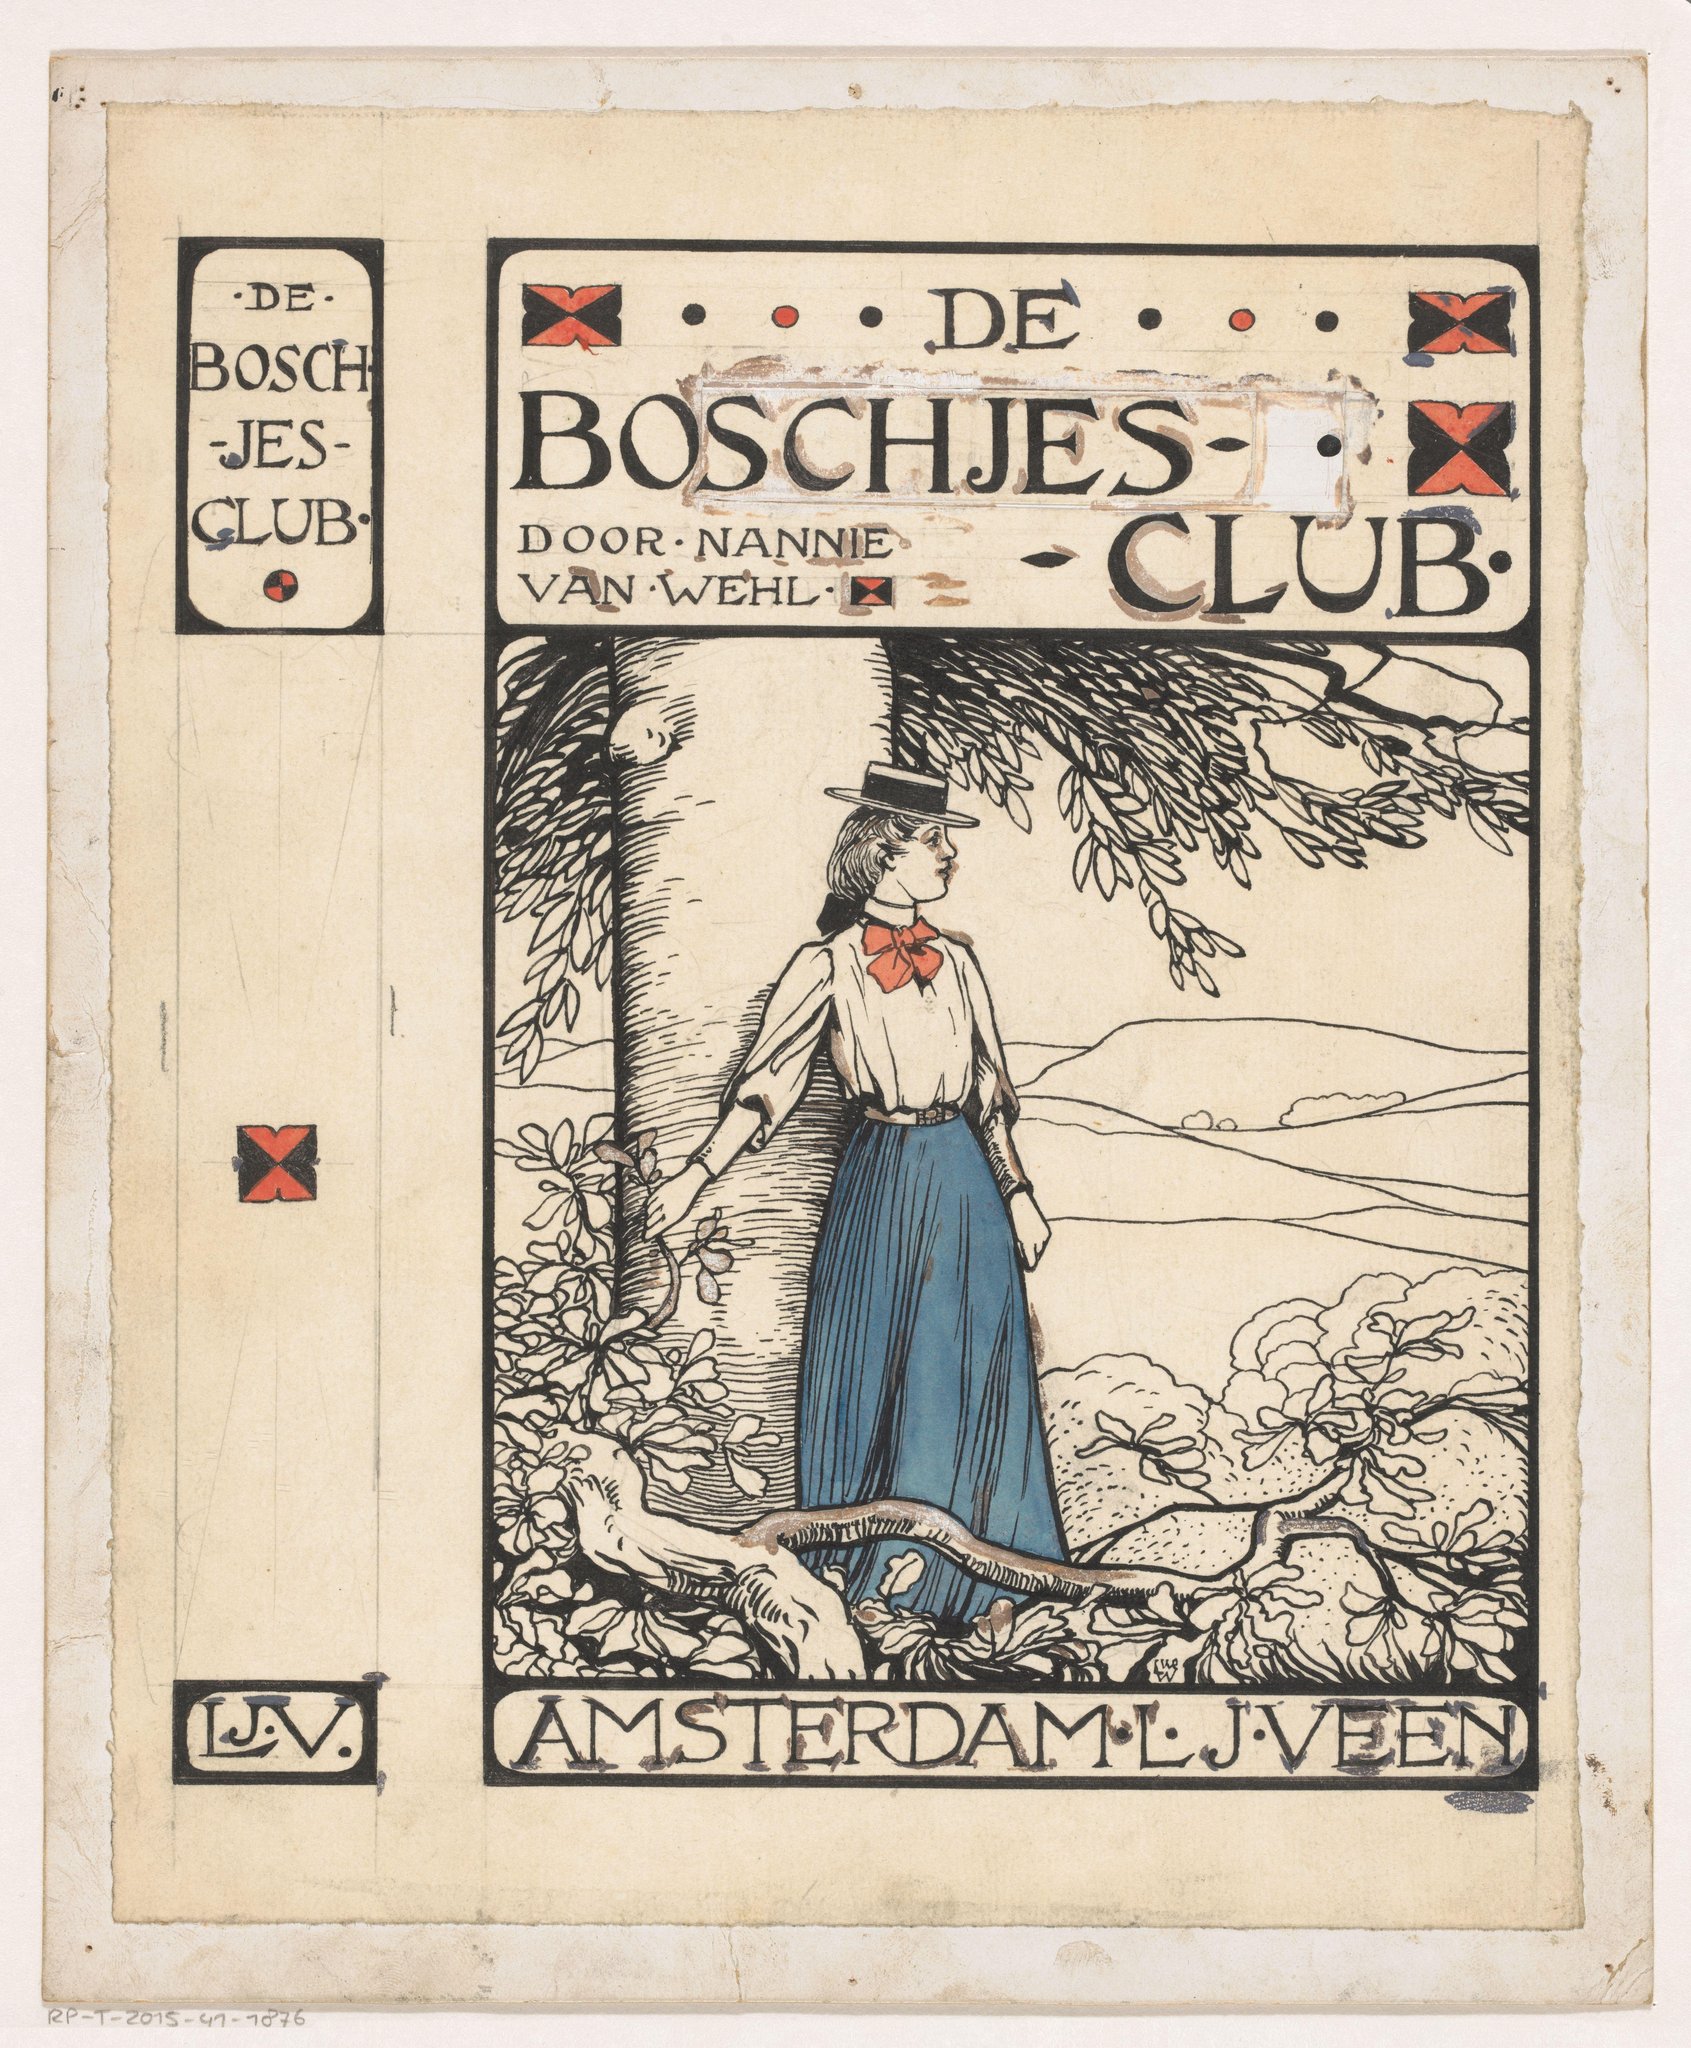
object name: study for binding design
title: Bandontwerp voor: Nannie van Wehl, De Boschjes-club, 1905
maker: willem wenckebach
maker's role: designer, draughtsman, painter, print maker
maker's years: 1860-1937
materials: cardboard, paint, ink, paper, pencil, watercolor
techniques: brush, pen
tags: adolescent, young woman, maiden, low hill country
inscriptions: monogram:, collector's mark: Lugt 2228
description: Een jonge vrouw met hoed leunt tegen een boom en kijkt uit over een heuvellandschap.